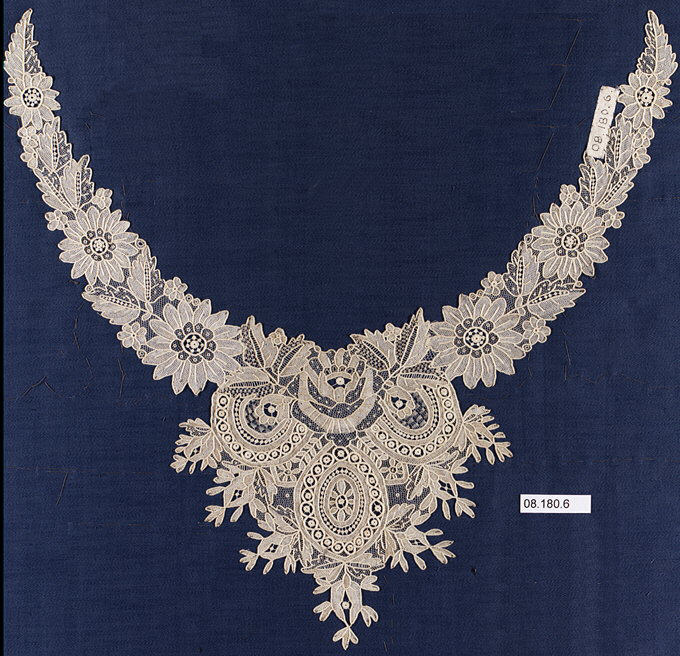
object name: neckpiece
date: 1801-1900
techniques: lace